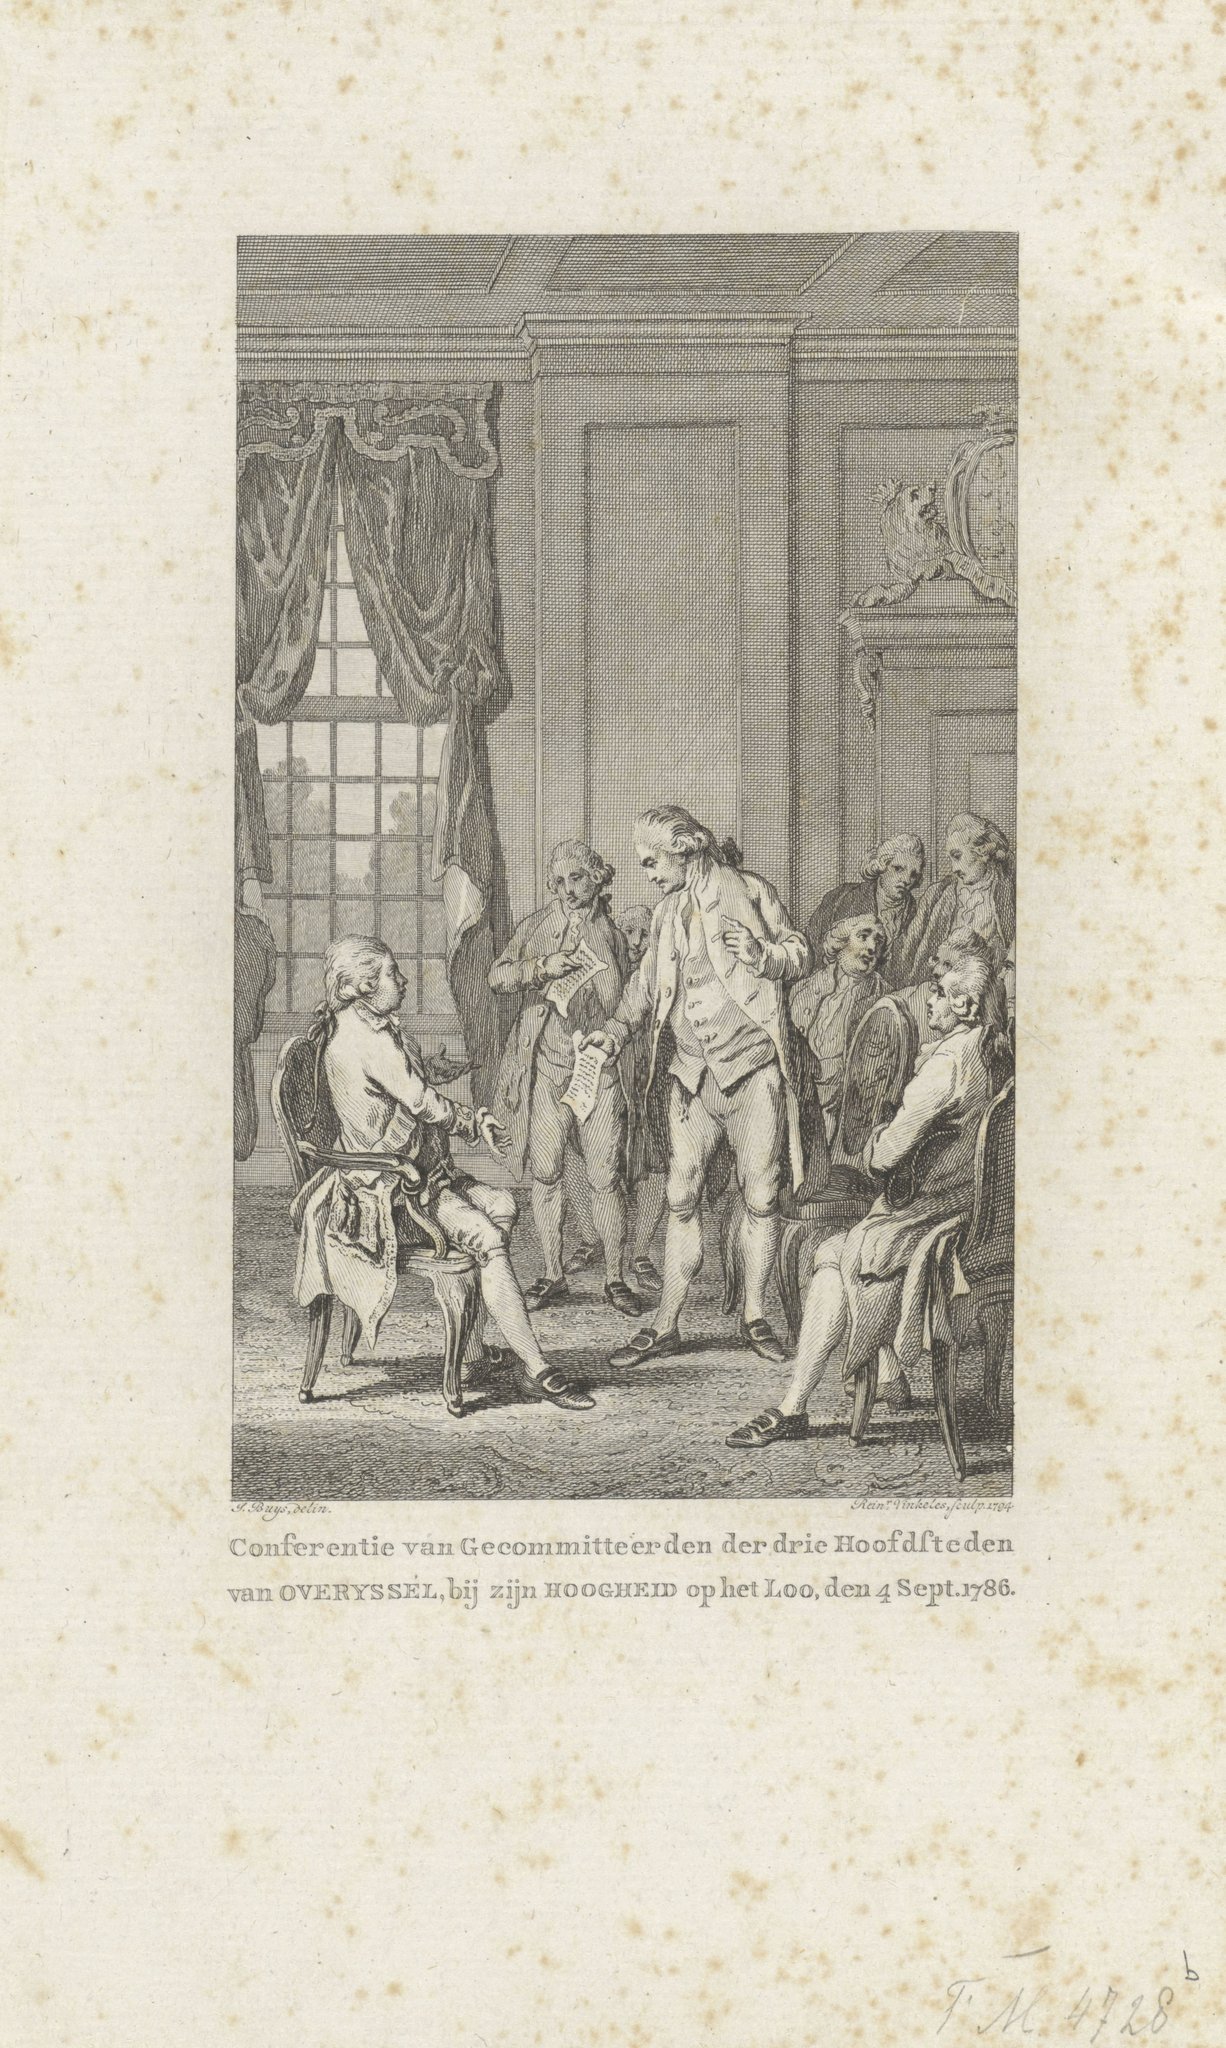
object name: history print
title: Conferentie van Gecommitteerden der drie Hoofdsteden van Overysssel, bij zijn Hoogheid op het Loo, den 4 Sept. 1786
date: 1794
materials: paper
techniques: engraving, etching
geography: amsterdam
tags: the hague, william v (prince of orange), governor, etc. of province, patriots (1780-1795)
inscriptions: date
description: Overleg op paleis Het Loo tussen prins Willem V en de gecommitteerden van de drie belangrijkste steden van Overijssel om schorsing van de maatregelen van de prins tegen de steden Hattem en Elburg te bepleiten, 4 september 1786.